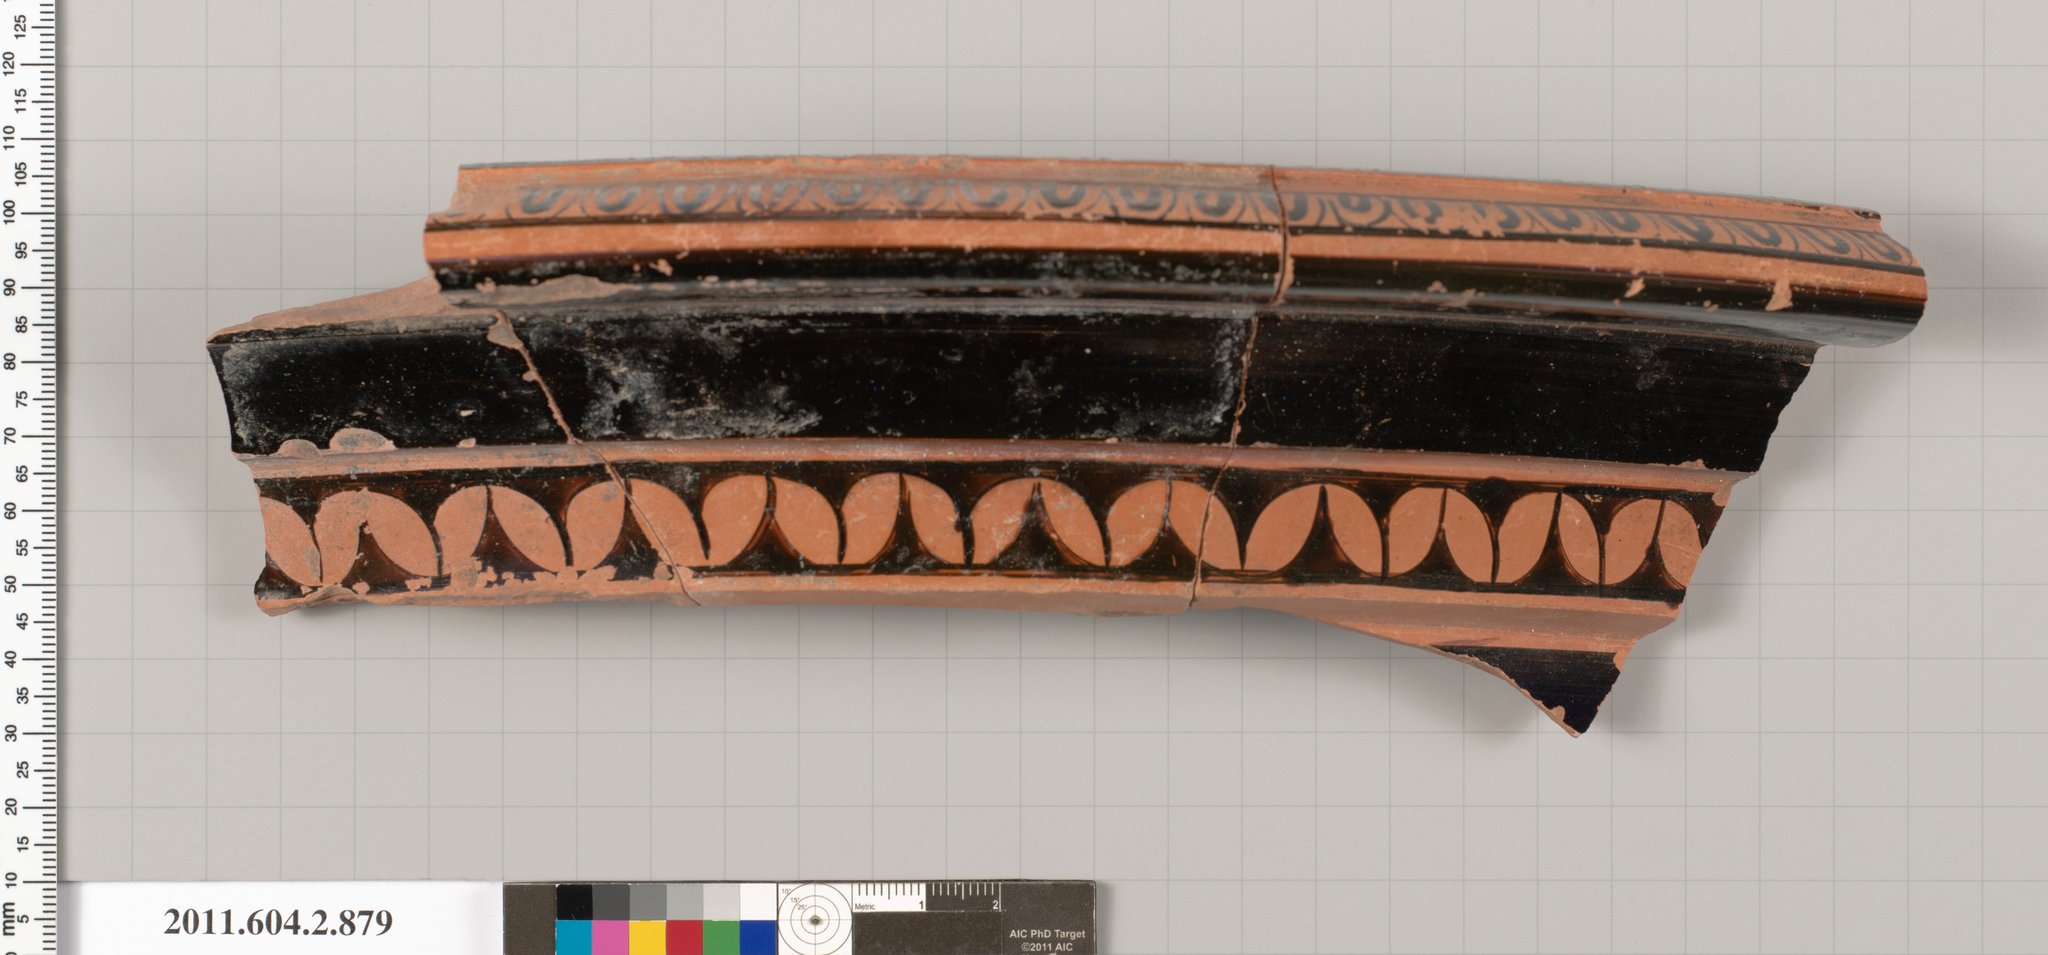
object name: bell krater fragment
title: Terracotta fragment of a bell-krater (bowl for mixing wine and water)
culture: greek, attic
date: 460-440 BCE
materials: terracotta